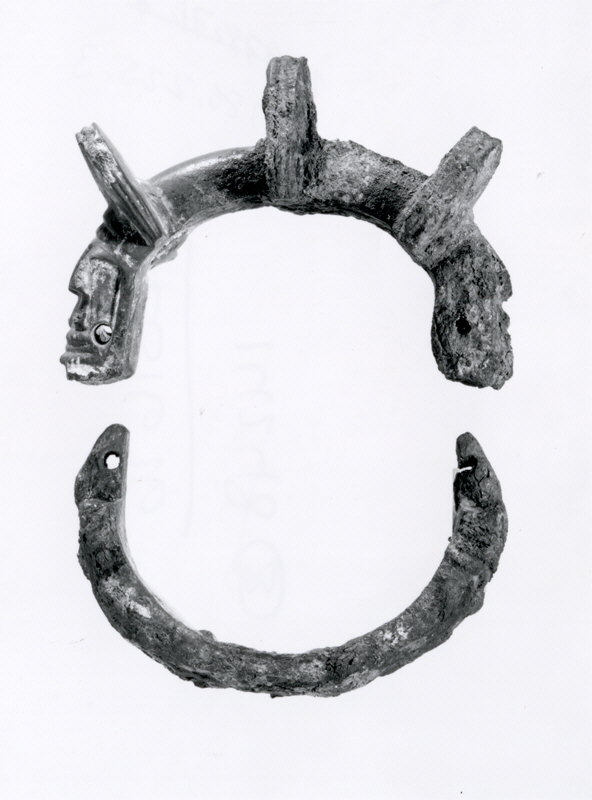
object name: bracelet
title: Hinged bracelet with lions' heads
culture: iranian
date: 800-601 BCE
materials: iron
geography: iran, probably from luristan